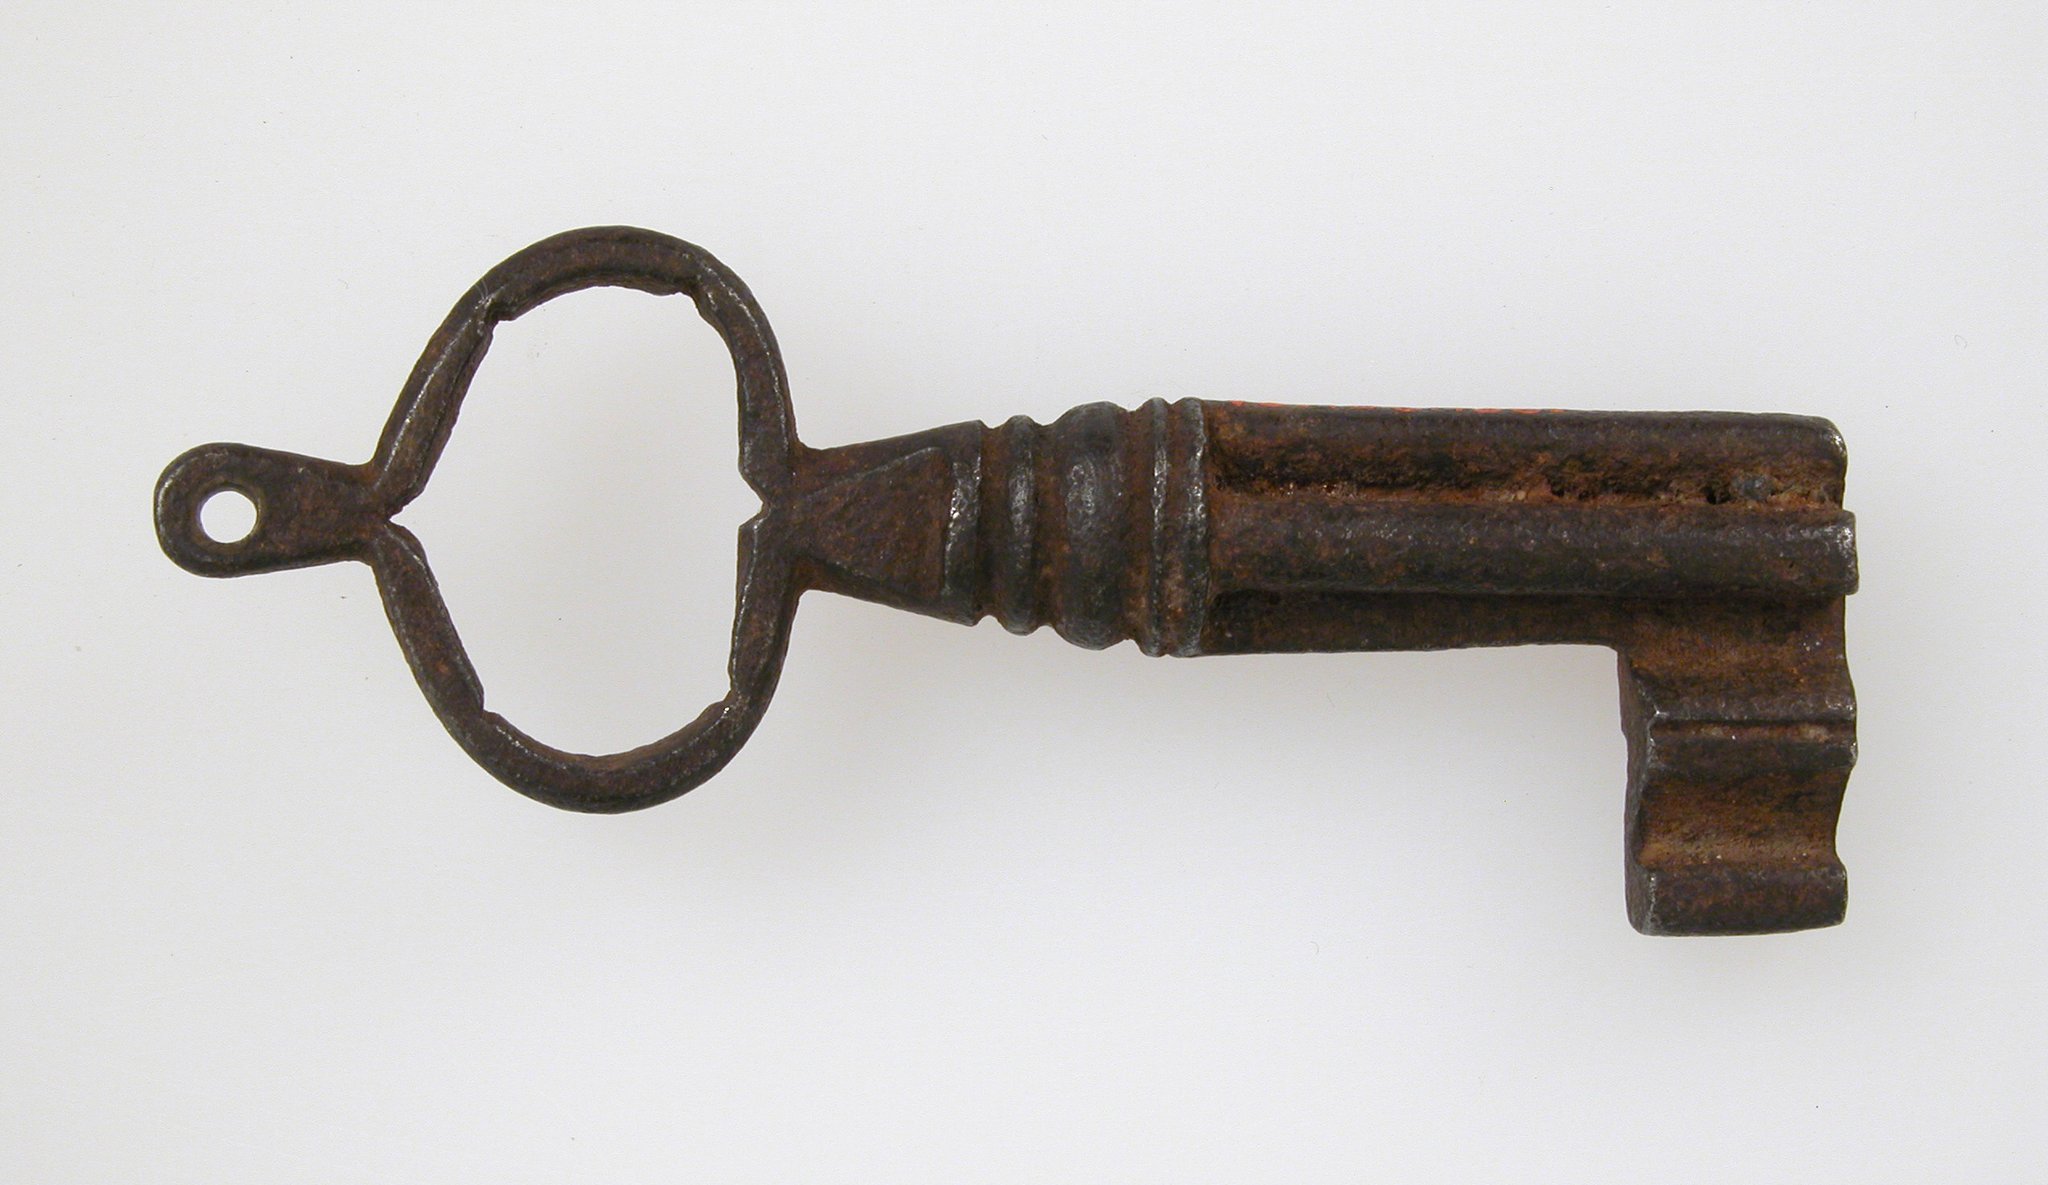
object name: key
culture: german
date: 1401-1500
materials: iron